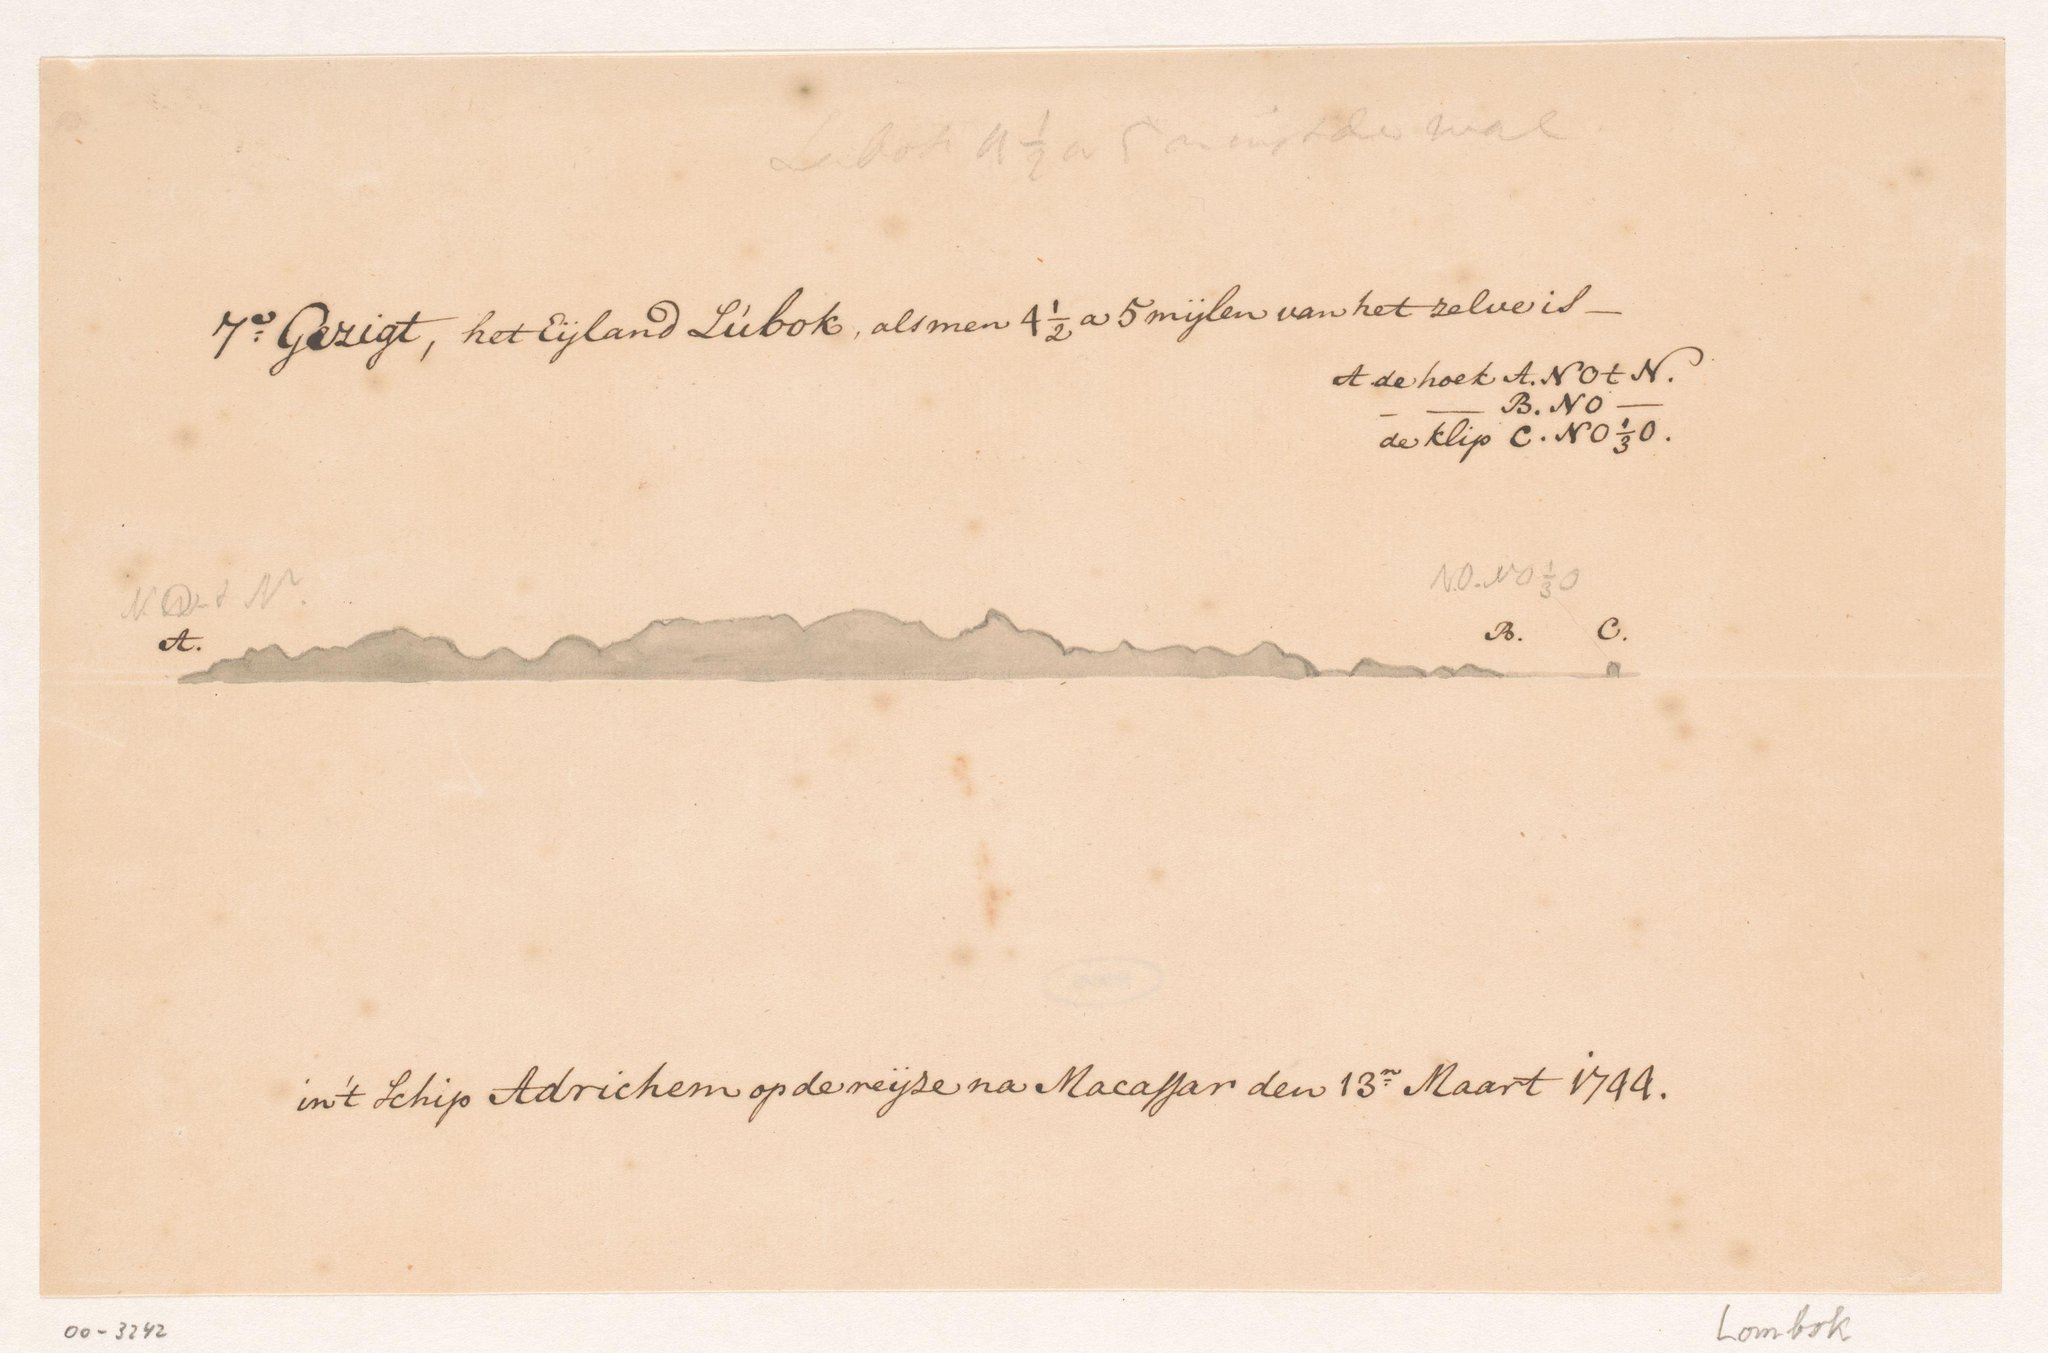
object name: drawing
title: 7e Gezigt, het Eijlandt Lúbok, alsmen 4 1/2 a 5 mijlen van het zelve is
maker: Anonymous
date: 1744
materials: ink, paper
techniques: brush, pen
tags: island (in tropical and sub-tropical regions)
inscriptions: collector's mark: Lugt 2228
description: Voorzien van de annotatie "in 't schip Adrichem op de reijze na Macassar den 13de Maart 1744".